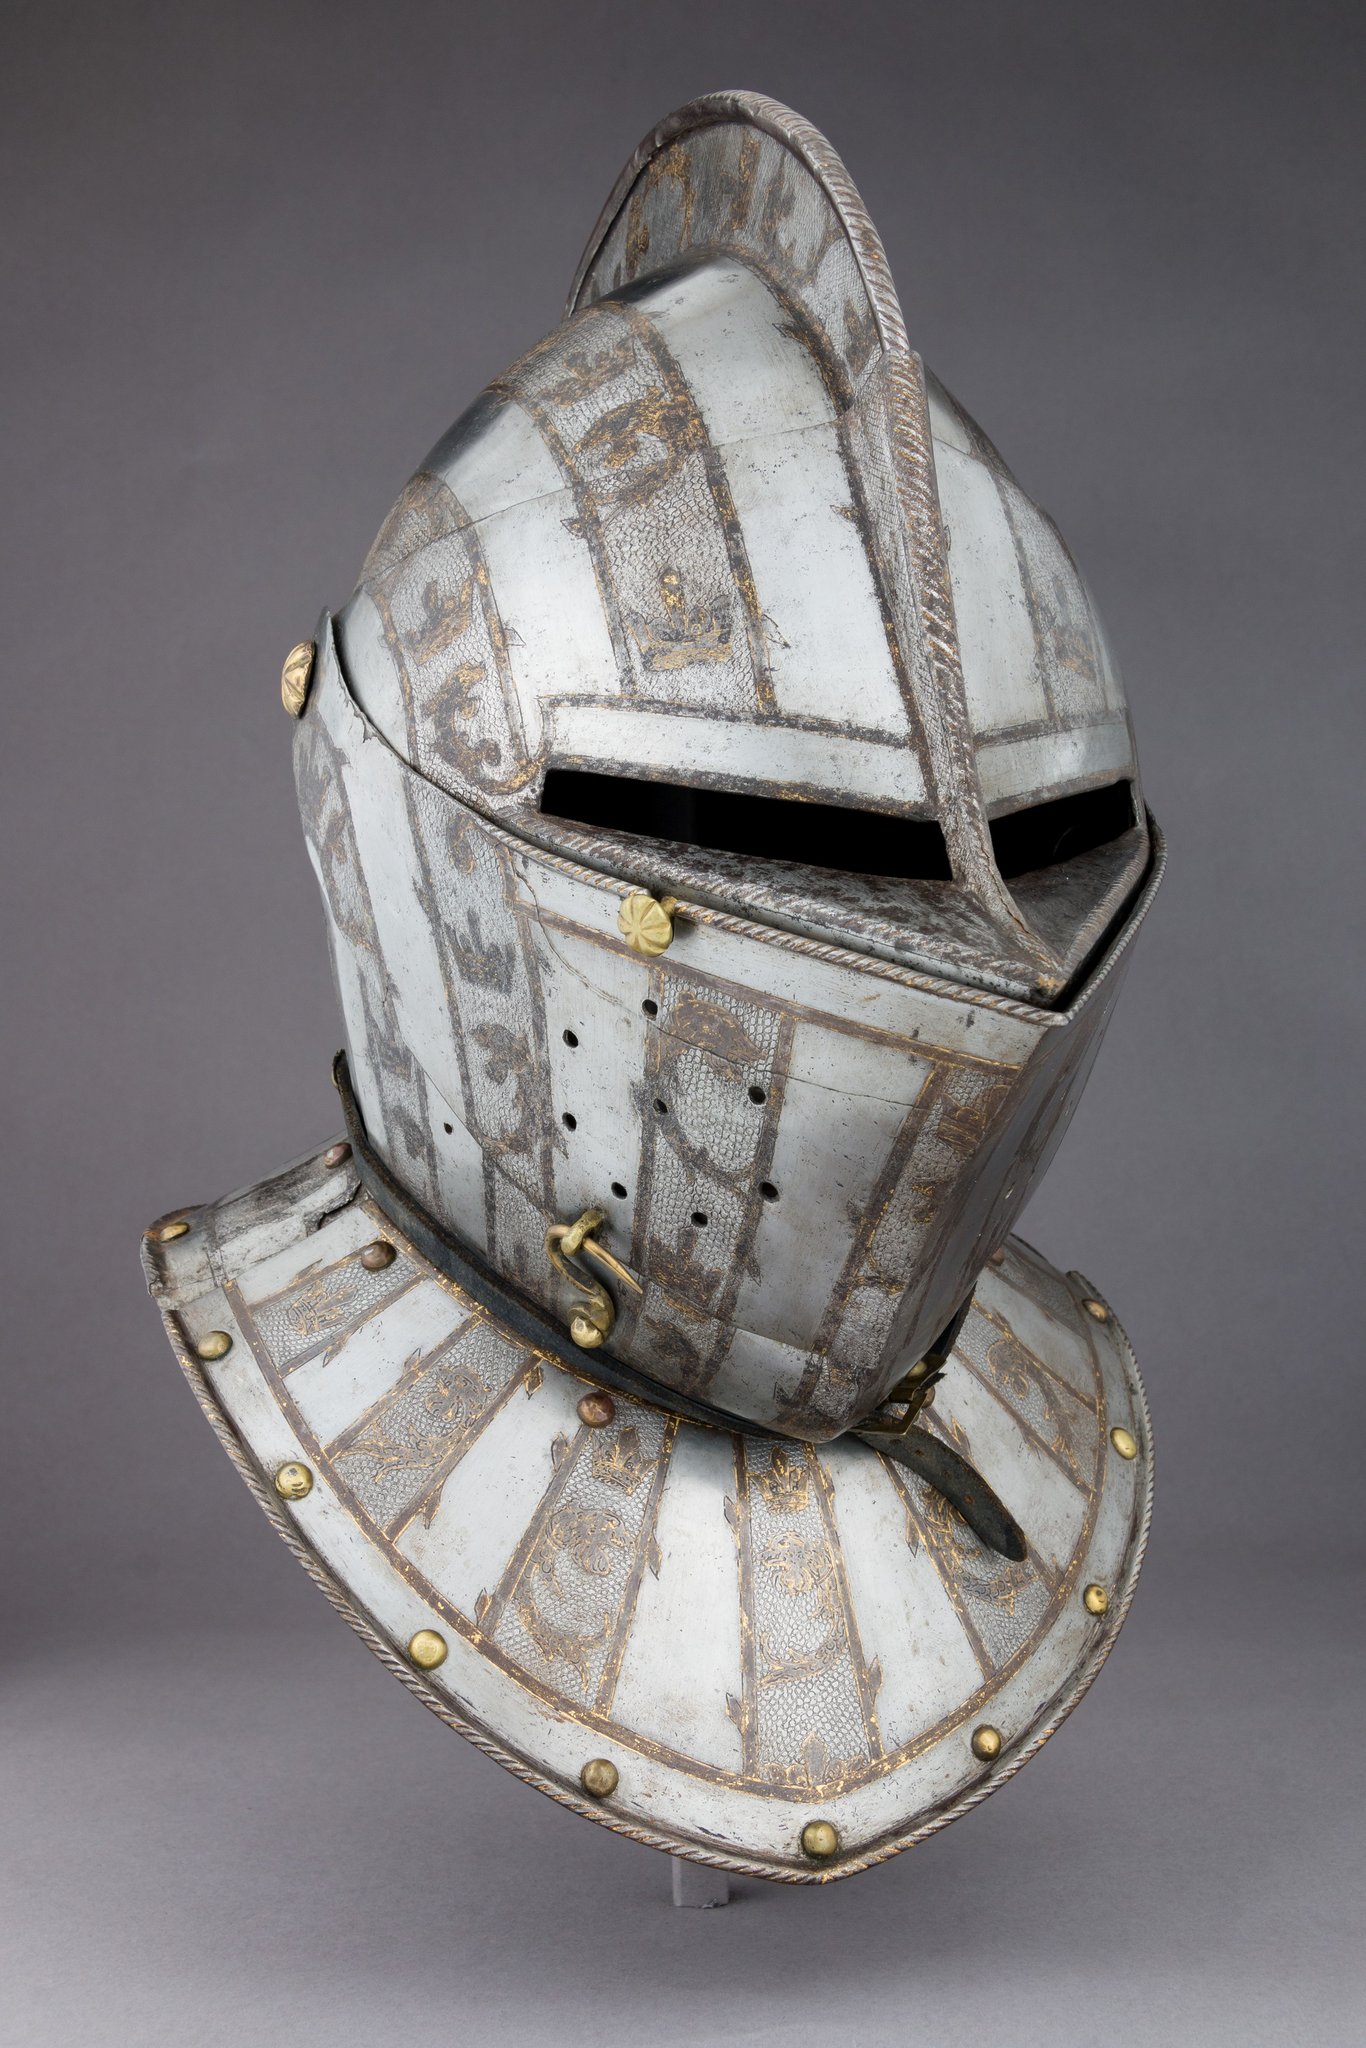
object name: close helmet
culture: french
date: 1600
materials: copper alloy, gold, leather, steel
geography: france